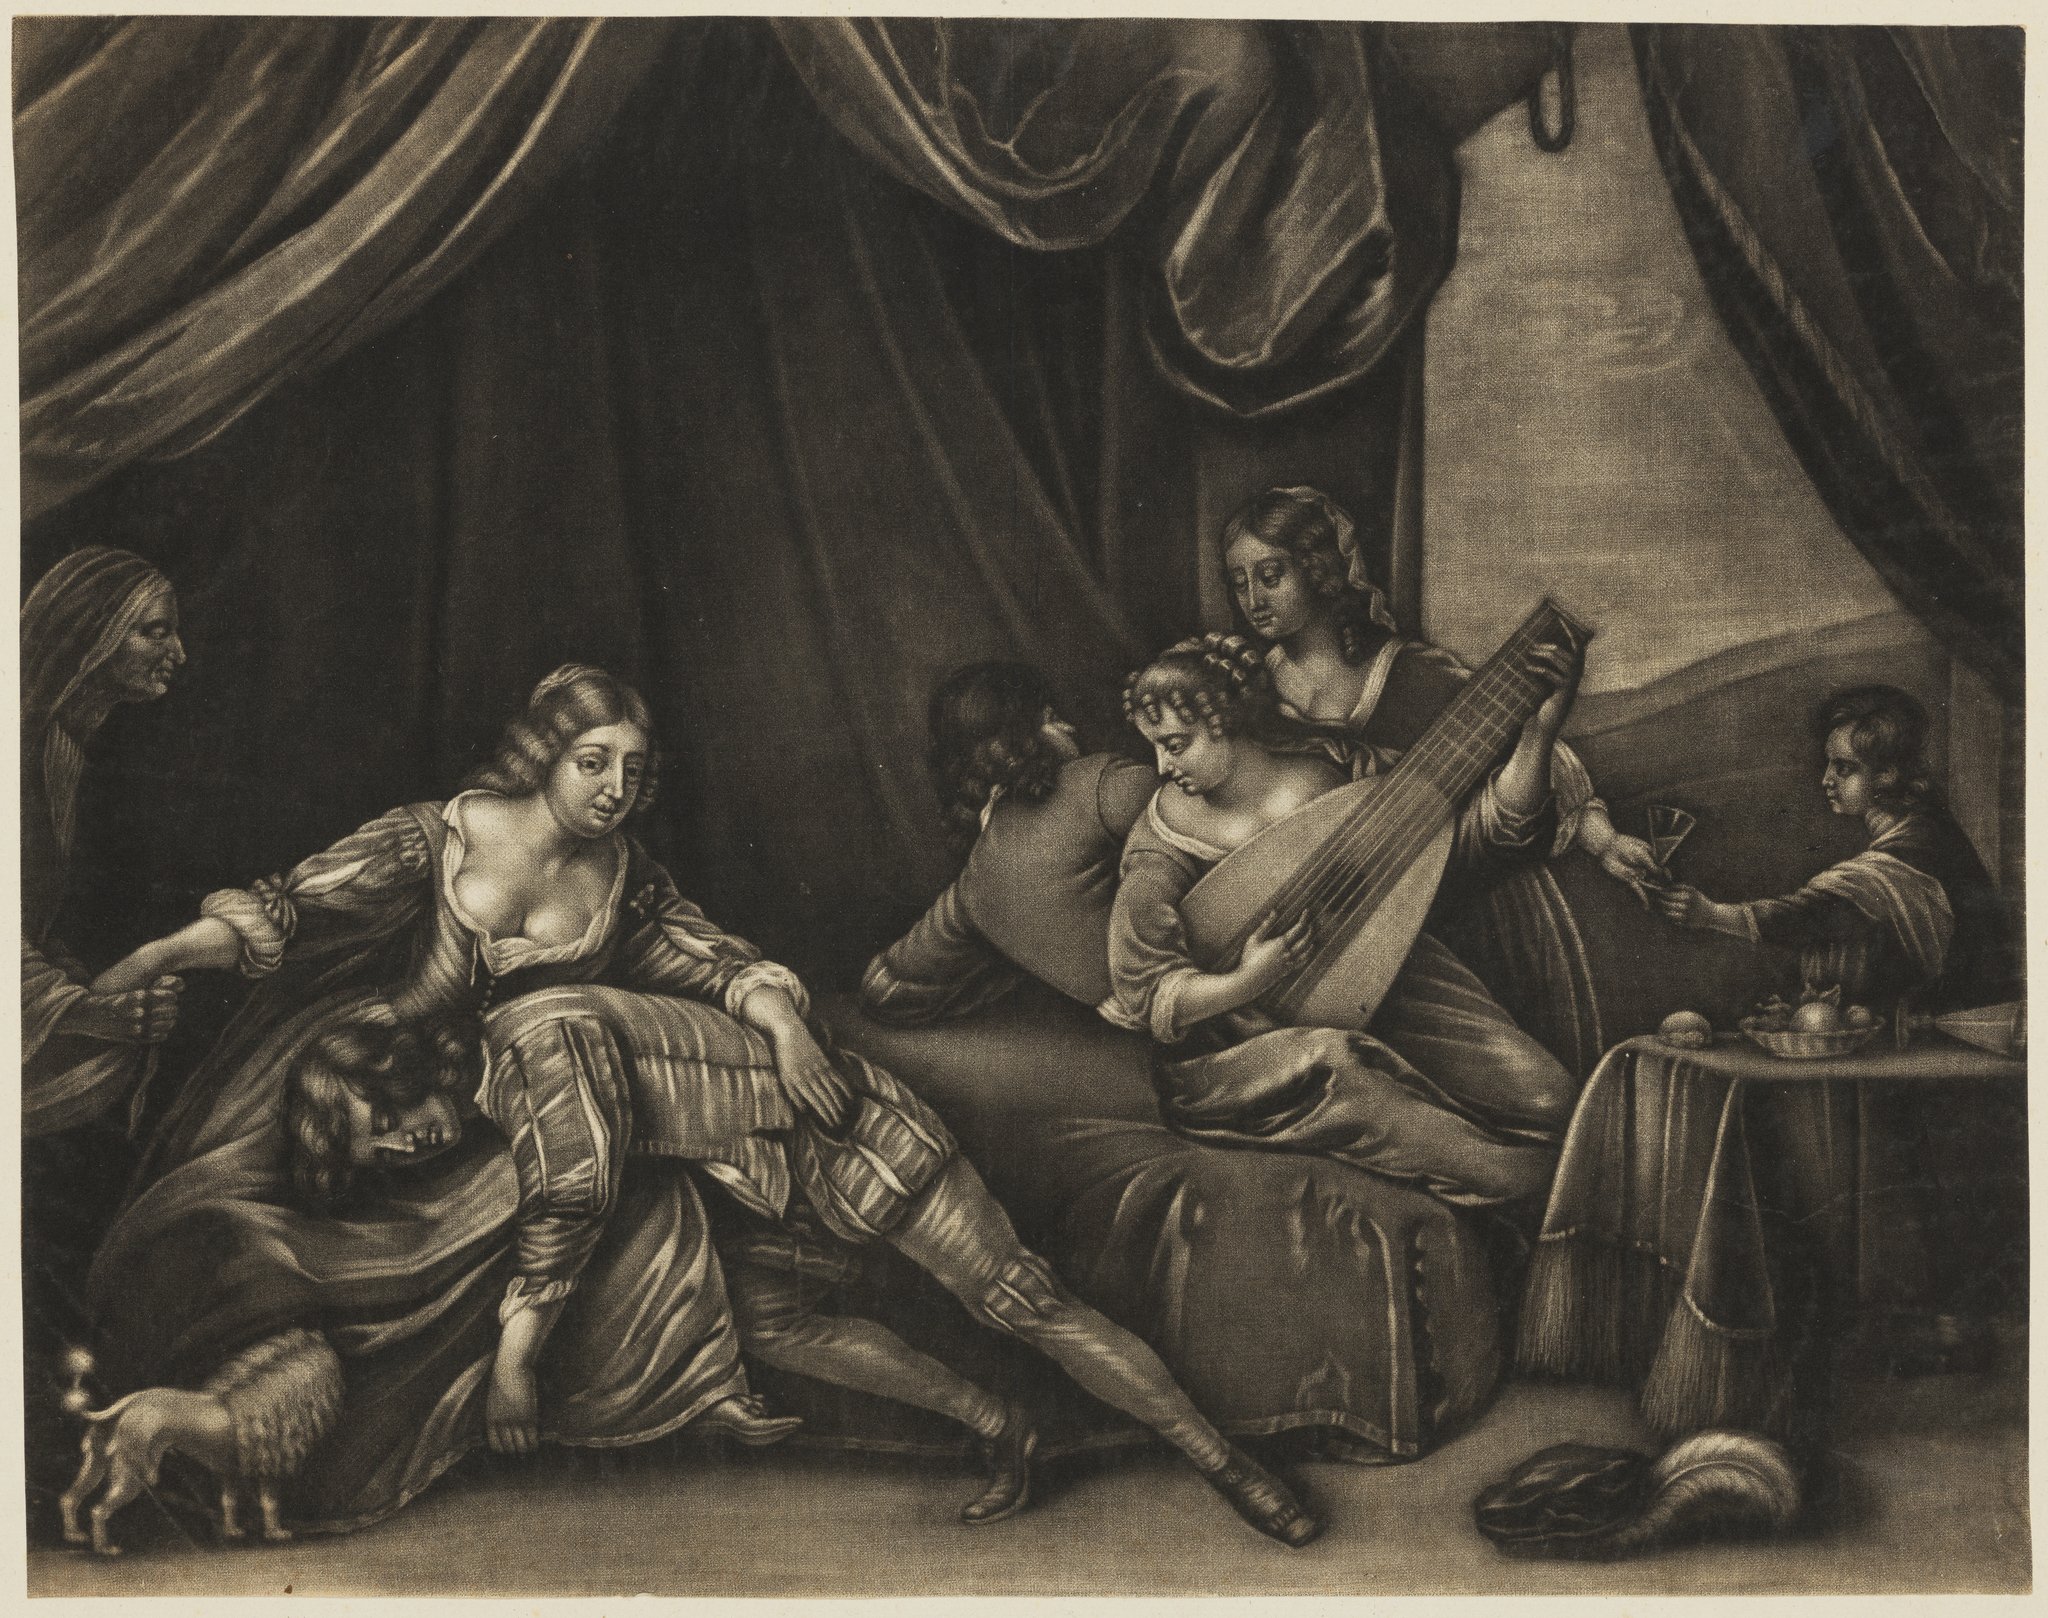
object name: print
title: Brothel Scene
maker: wallerant vaillant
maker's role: artist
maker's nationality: dutch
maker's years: 1623-1677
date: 1640-1677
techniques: mezzotint